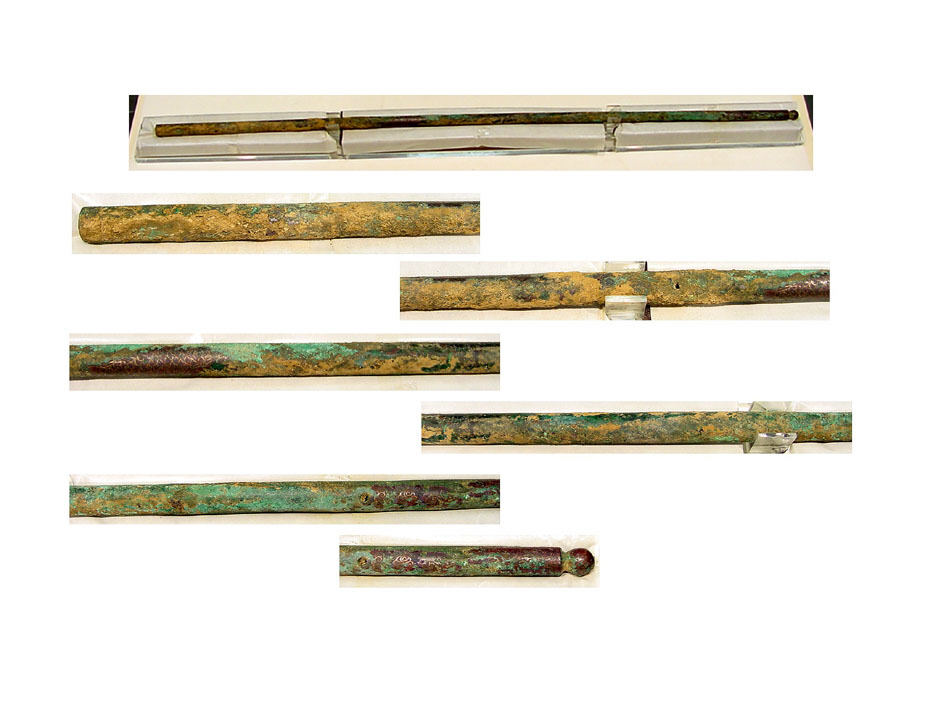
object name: tent pole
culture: chinese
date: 907-1125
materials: bronze, silver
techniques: inlay